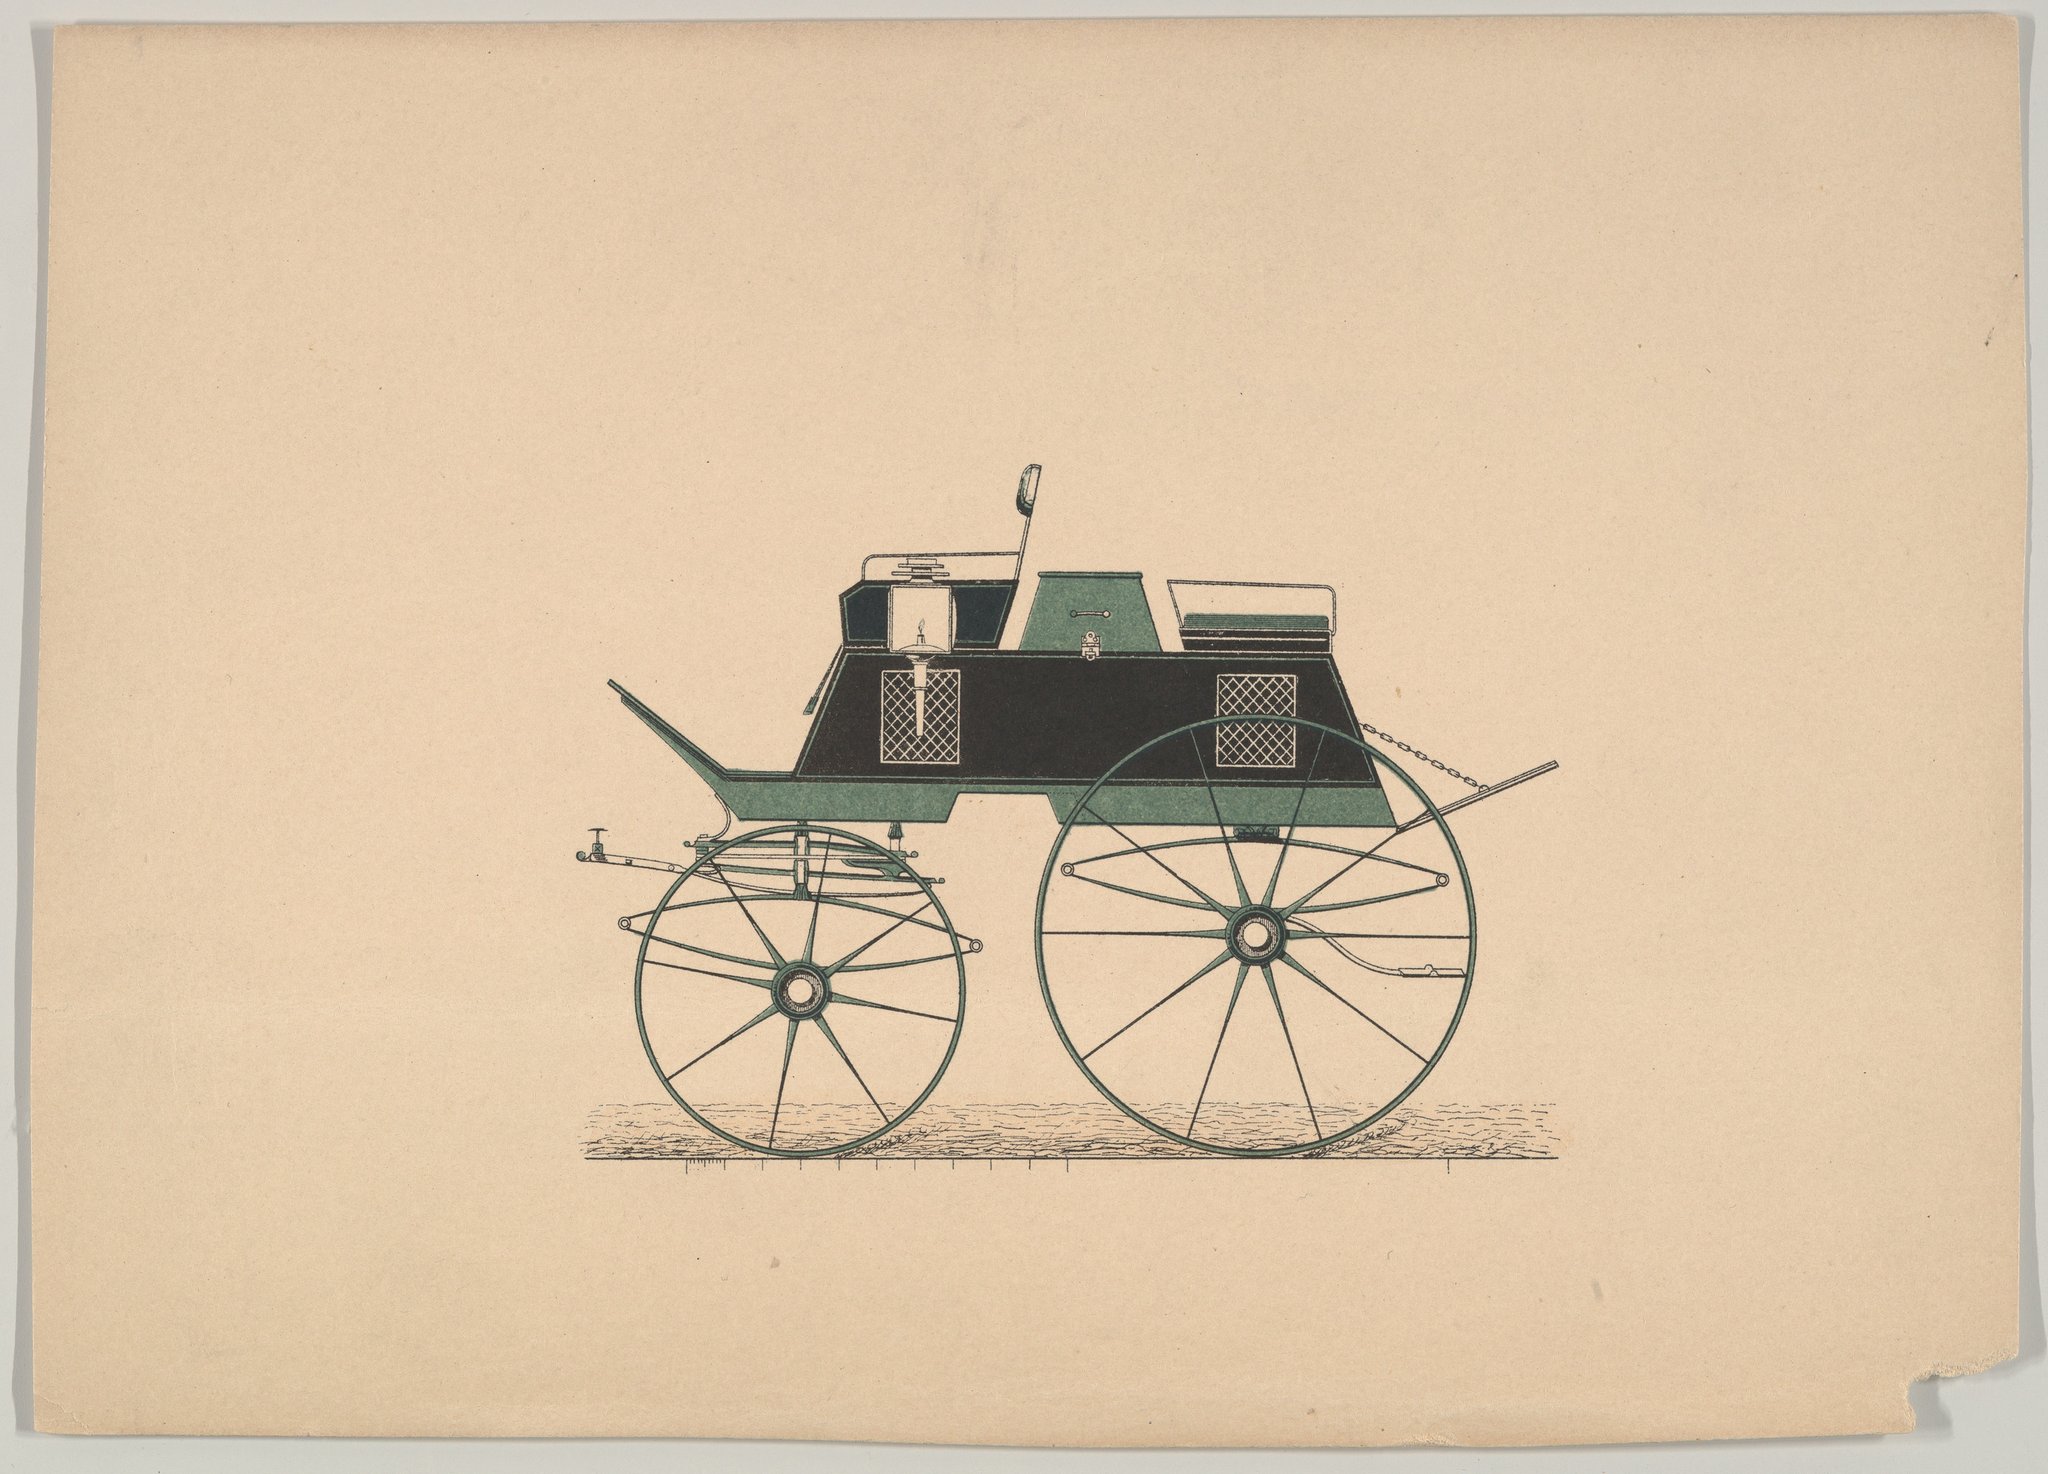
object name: print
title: Four Wheel Dog Cart (no number)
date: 1870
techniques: lithograph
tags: carriages